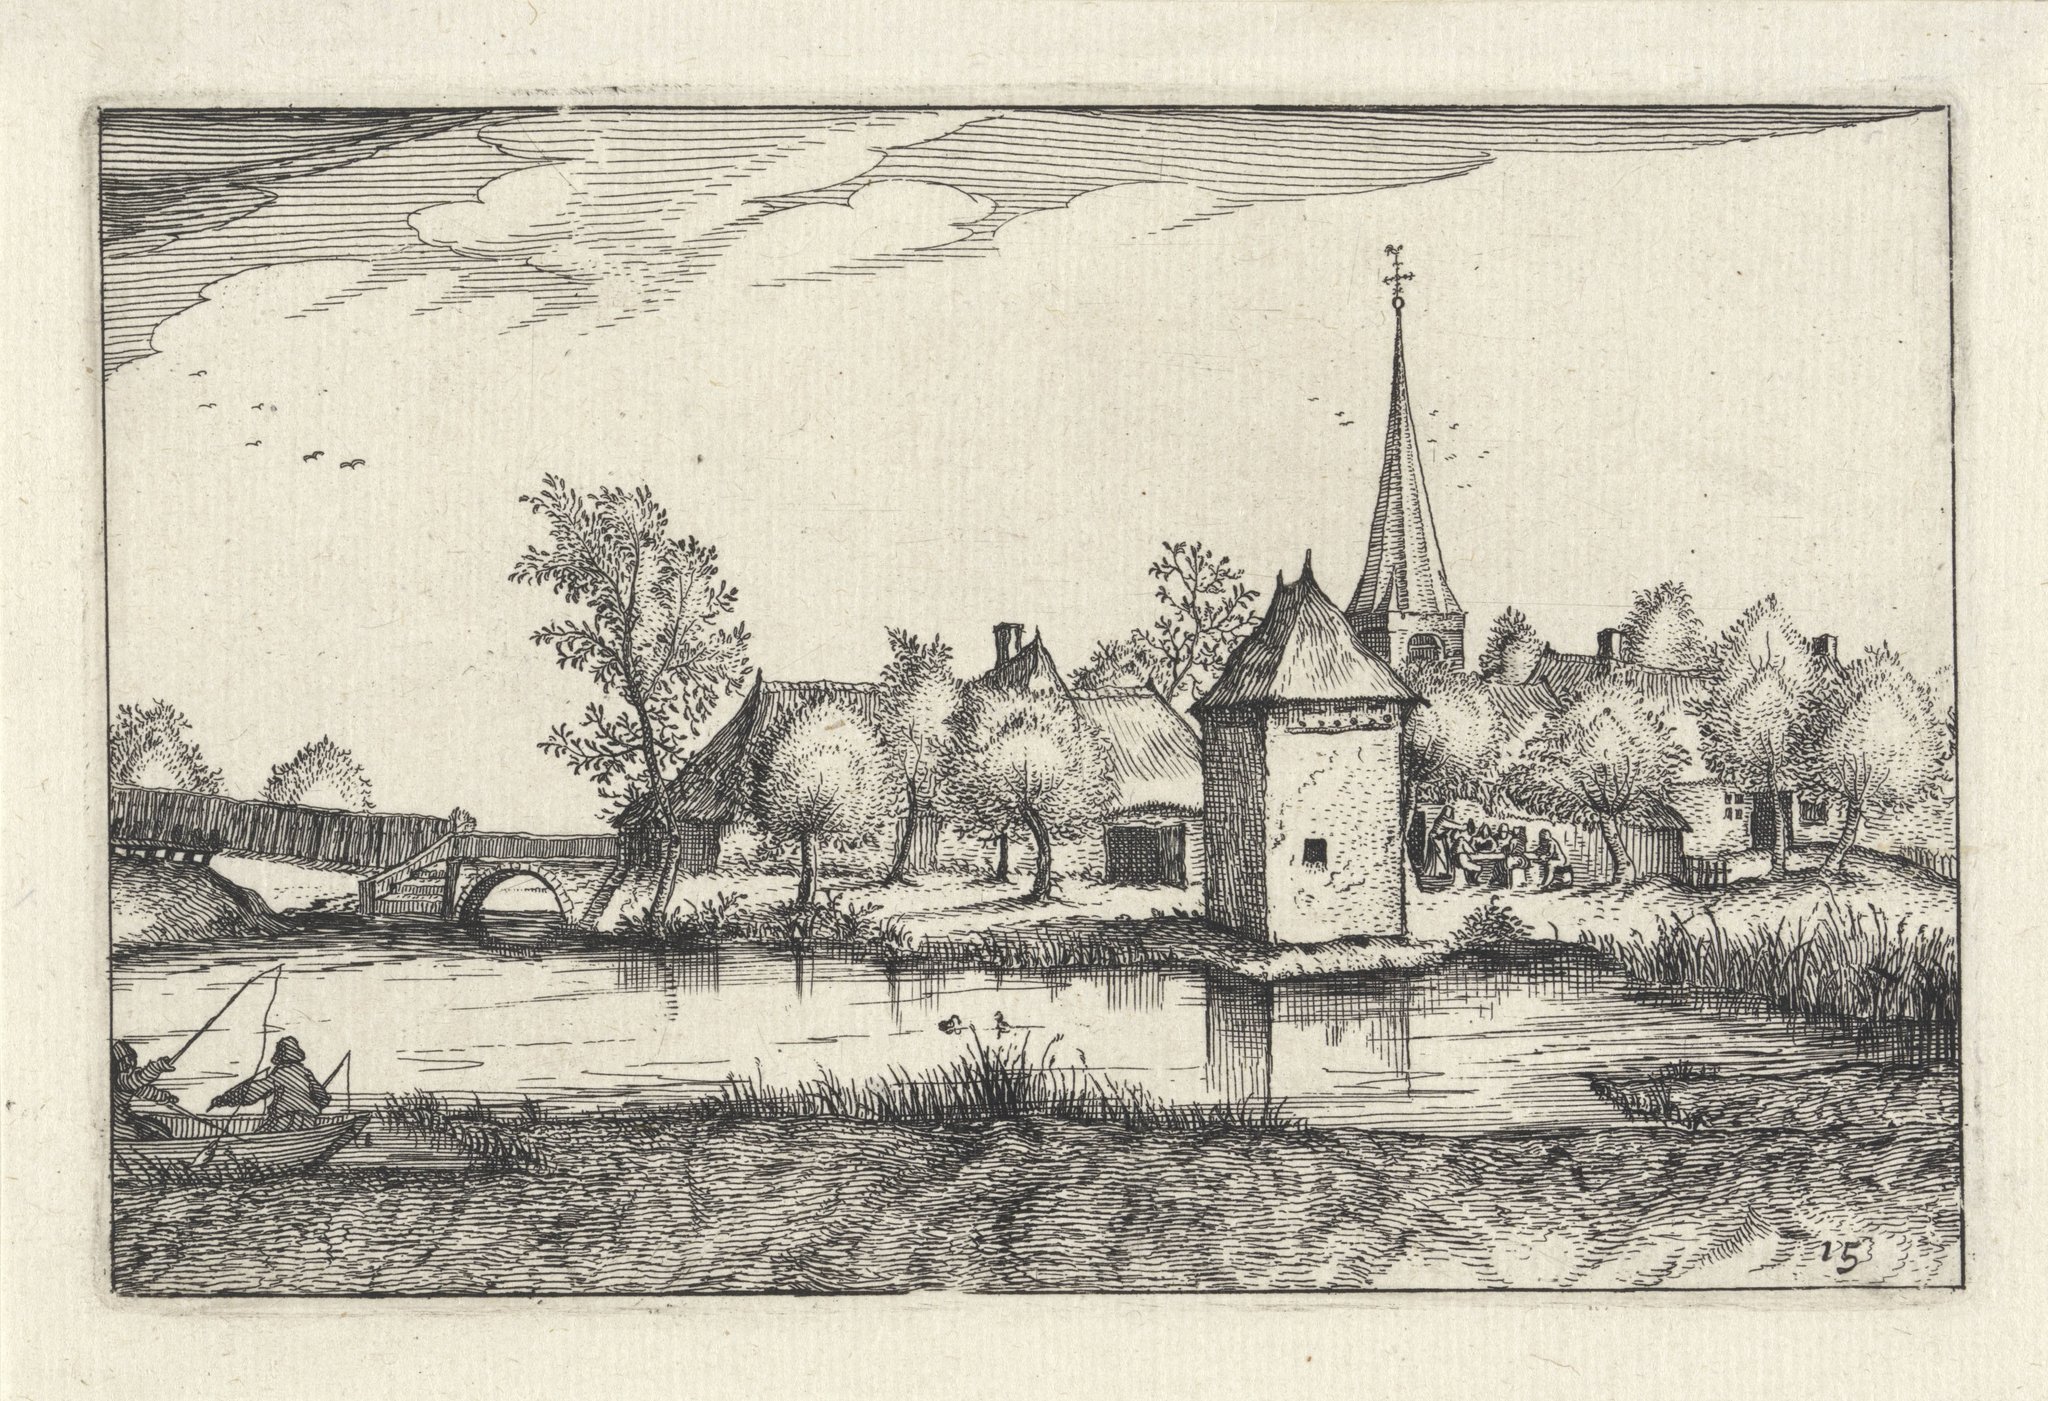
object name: print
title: Landschappen met gebouwen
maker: claes jansz. visscher (ii)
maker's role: draughtsman, print maker, publisher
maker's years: 1586-1652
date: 1620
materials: paper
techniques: etching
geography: amsterdam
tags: village, pond, pool, fisherman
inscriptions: collector's mark: Lugt 240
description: Gezicht op een vijver, met twee vissers, waarachter een dorp ligt. In het midden van het dorp is een kerktoren te zien en links een brug.